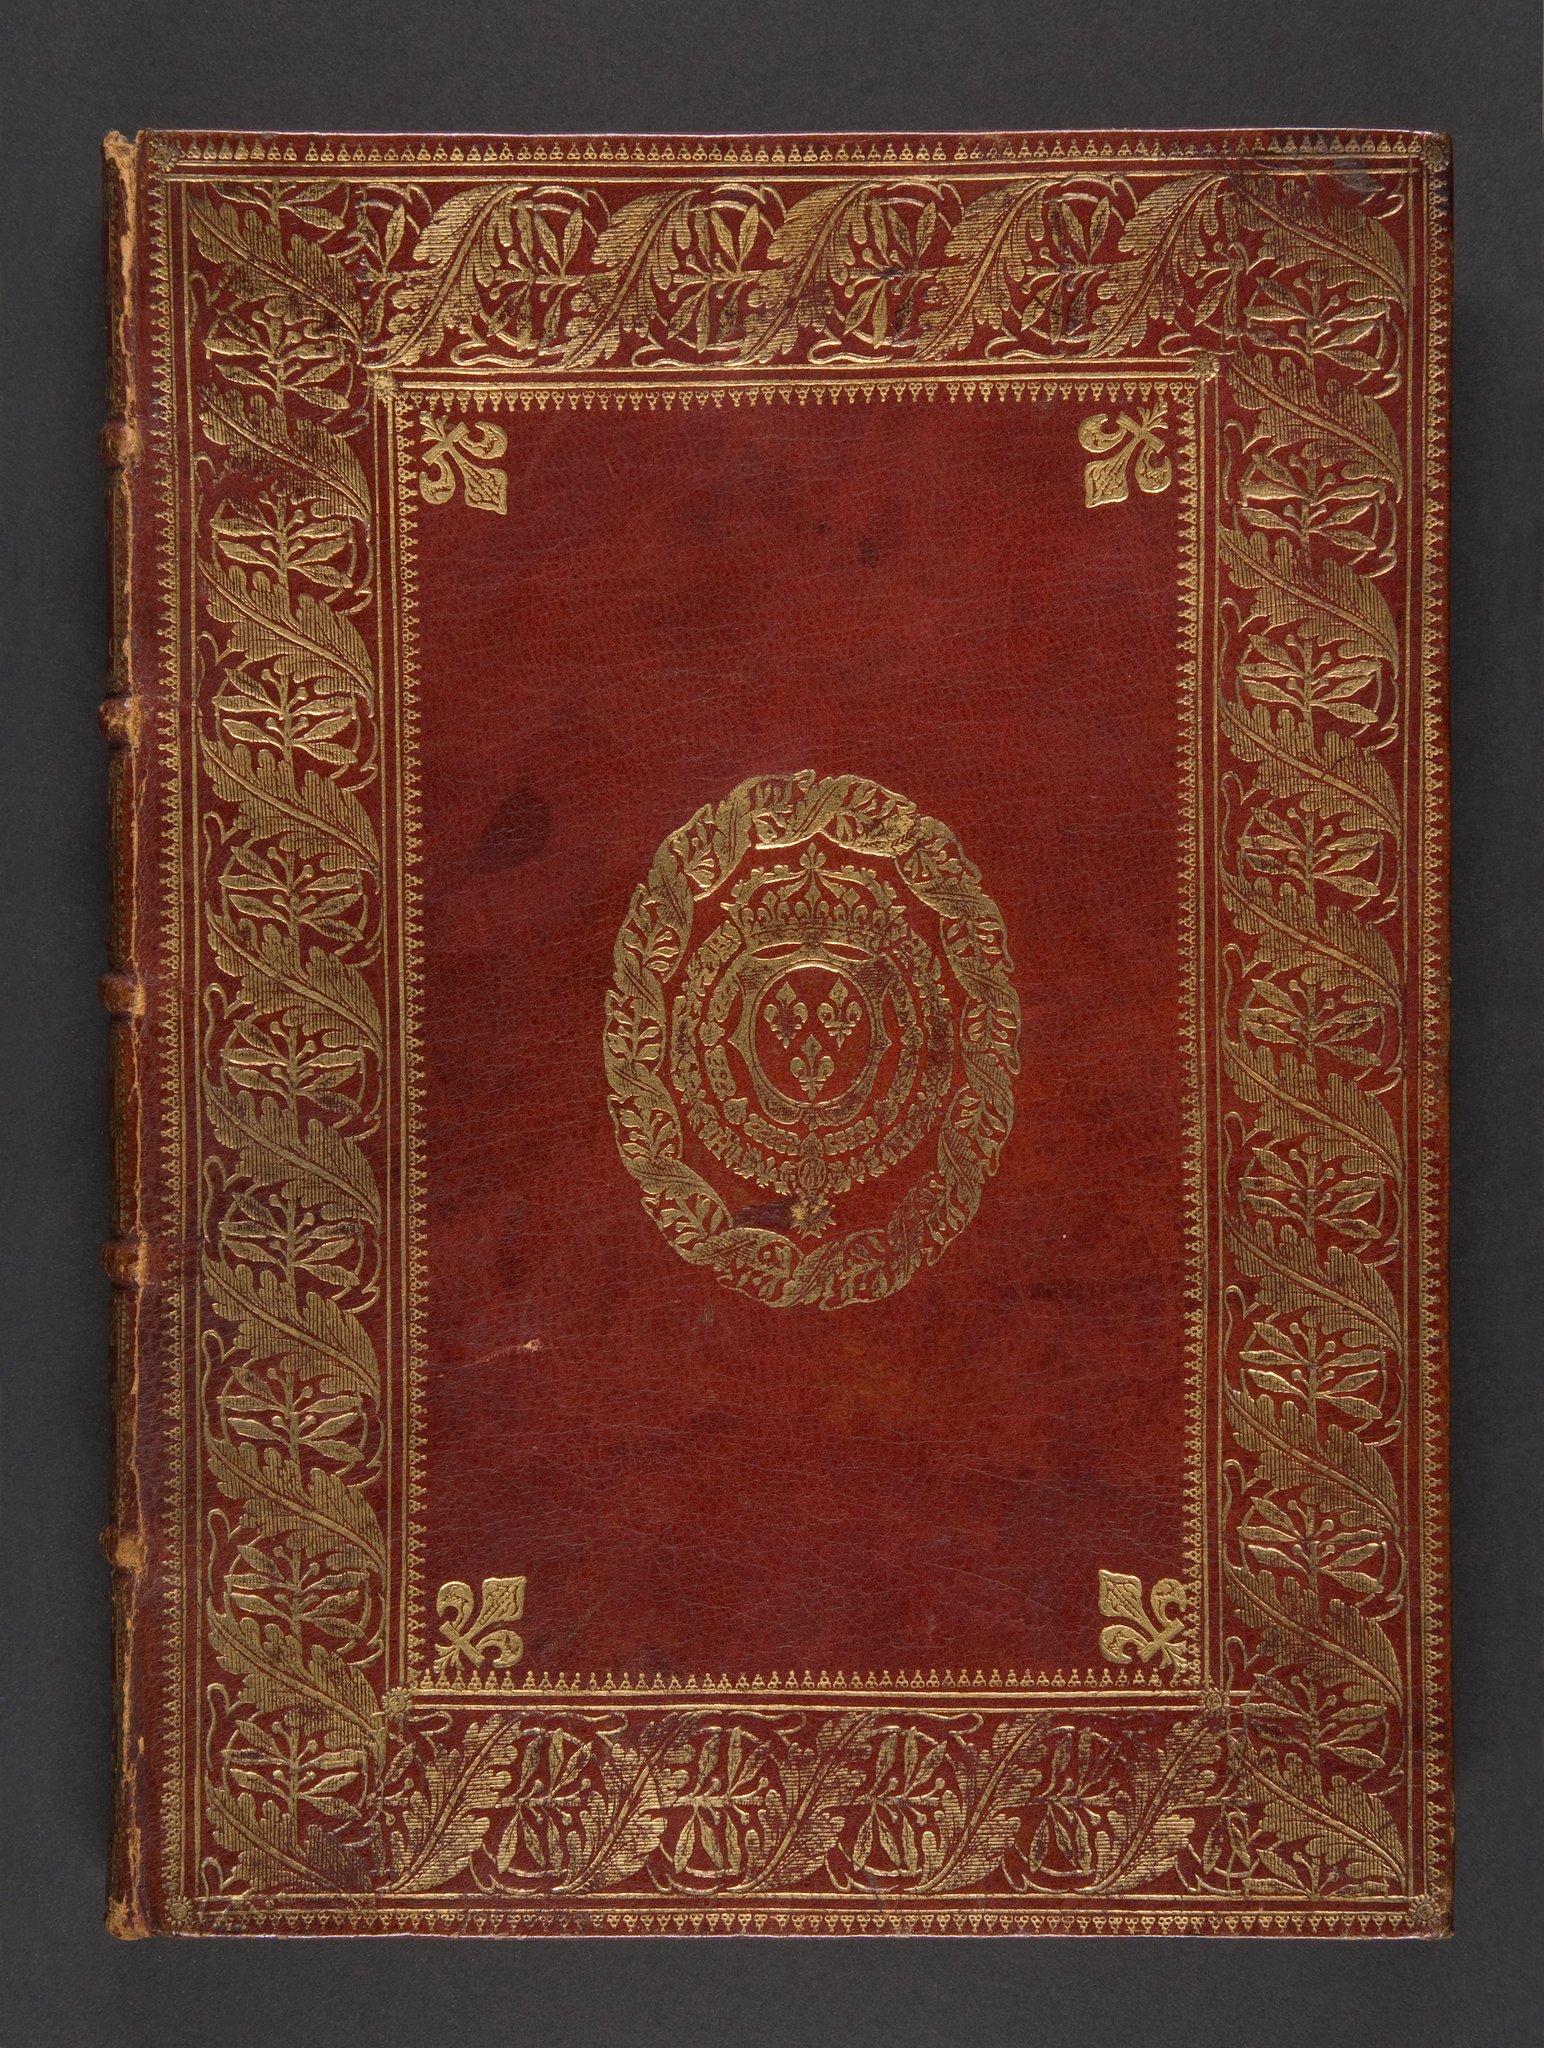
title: Proposition concernant le payement et la police des troupes du roy, qui produira à Sa Majesté une finance de six millions deux cens soixante mille livres inventée et proposée par le baron de Sparre, circa 1740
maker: padeloup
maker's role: binder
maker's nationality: french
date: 1740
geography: france